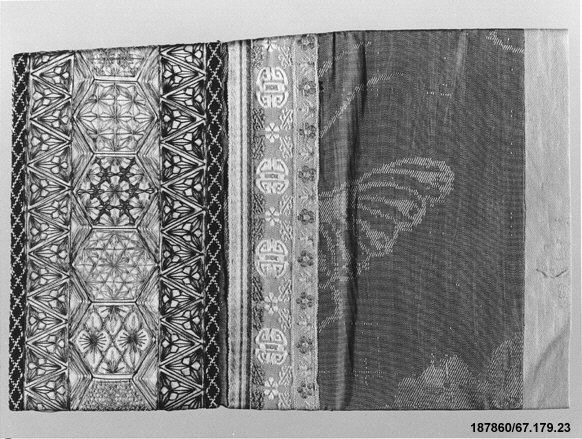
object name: cuff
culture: chinese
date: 1801-1900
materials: silk